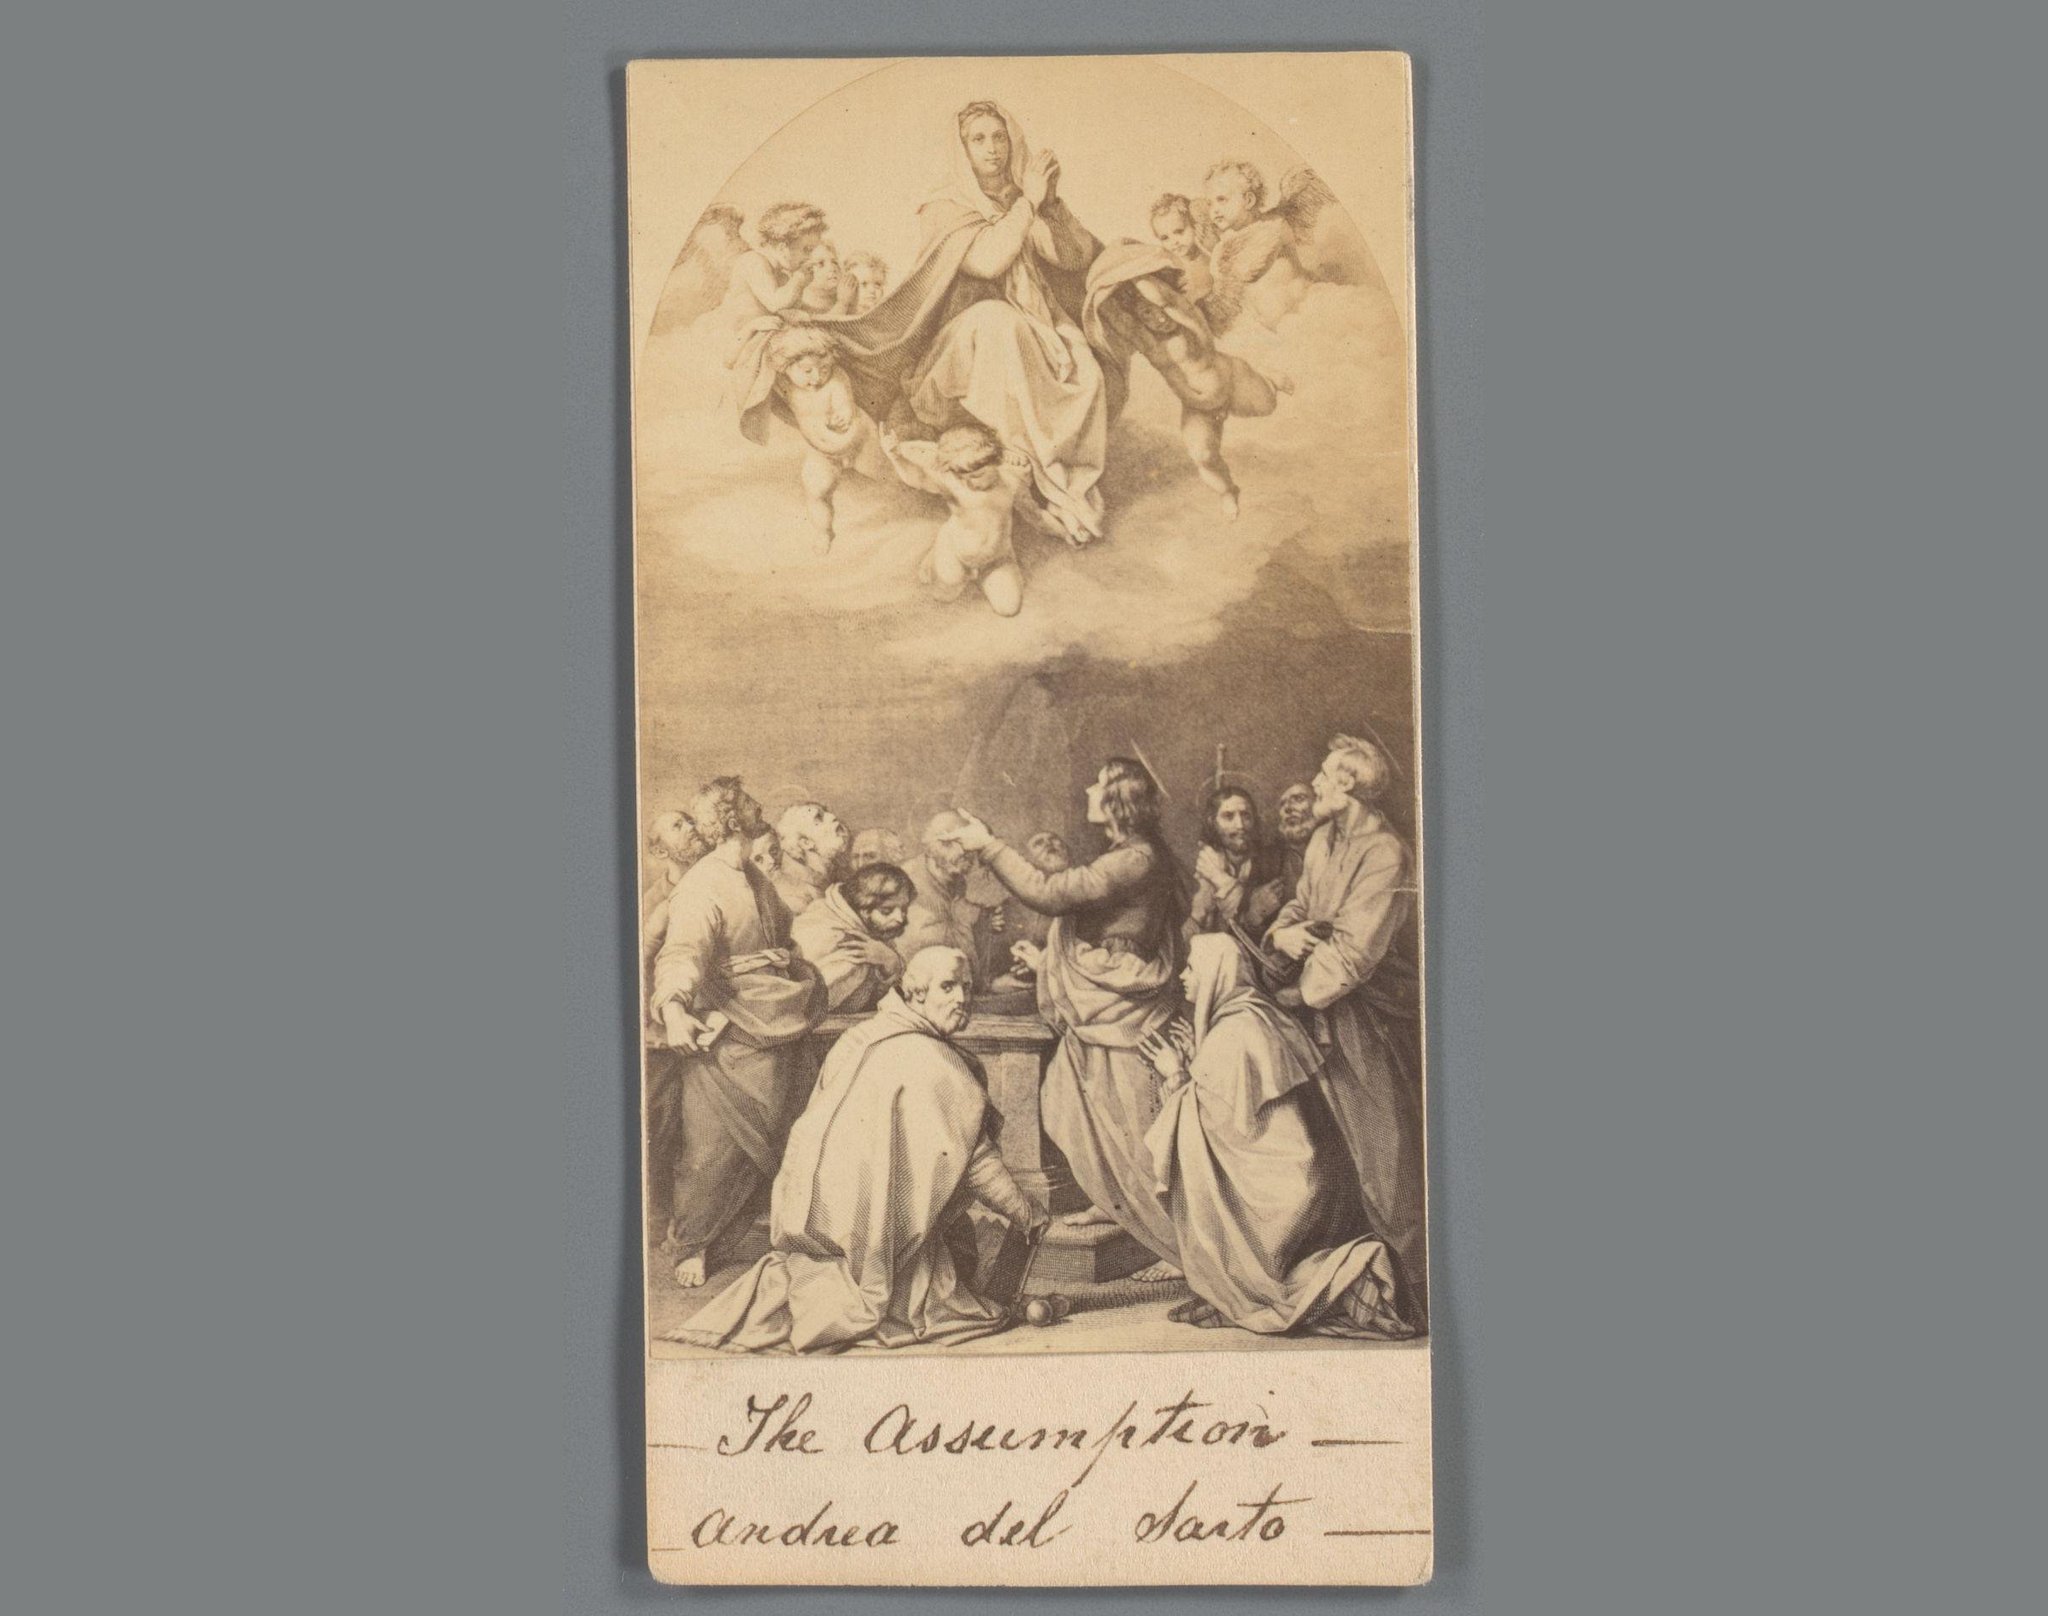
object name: reproduction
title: Fotoreproductie van een prent naar een schilderij van de hemelvaart van Maria door Andrea del Sarto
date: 1870-1900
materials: paper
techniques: albumen print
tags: the assumption of mary ('assumptio corporis'): she is borne into heaven by angels